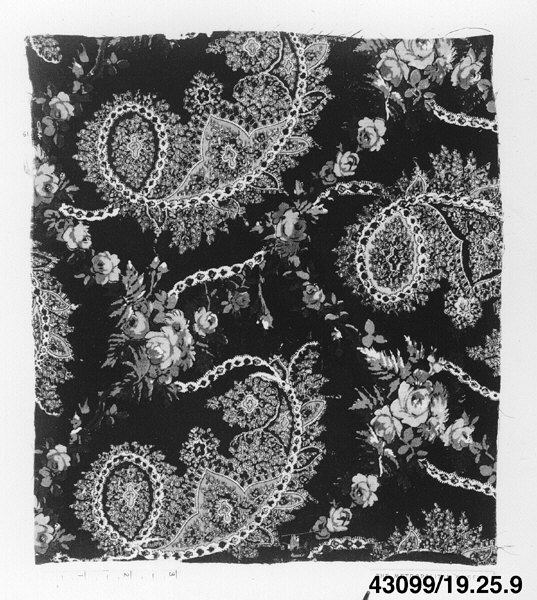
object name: sample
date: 1830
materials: wool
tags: flowers